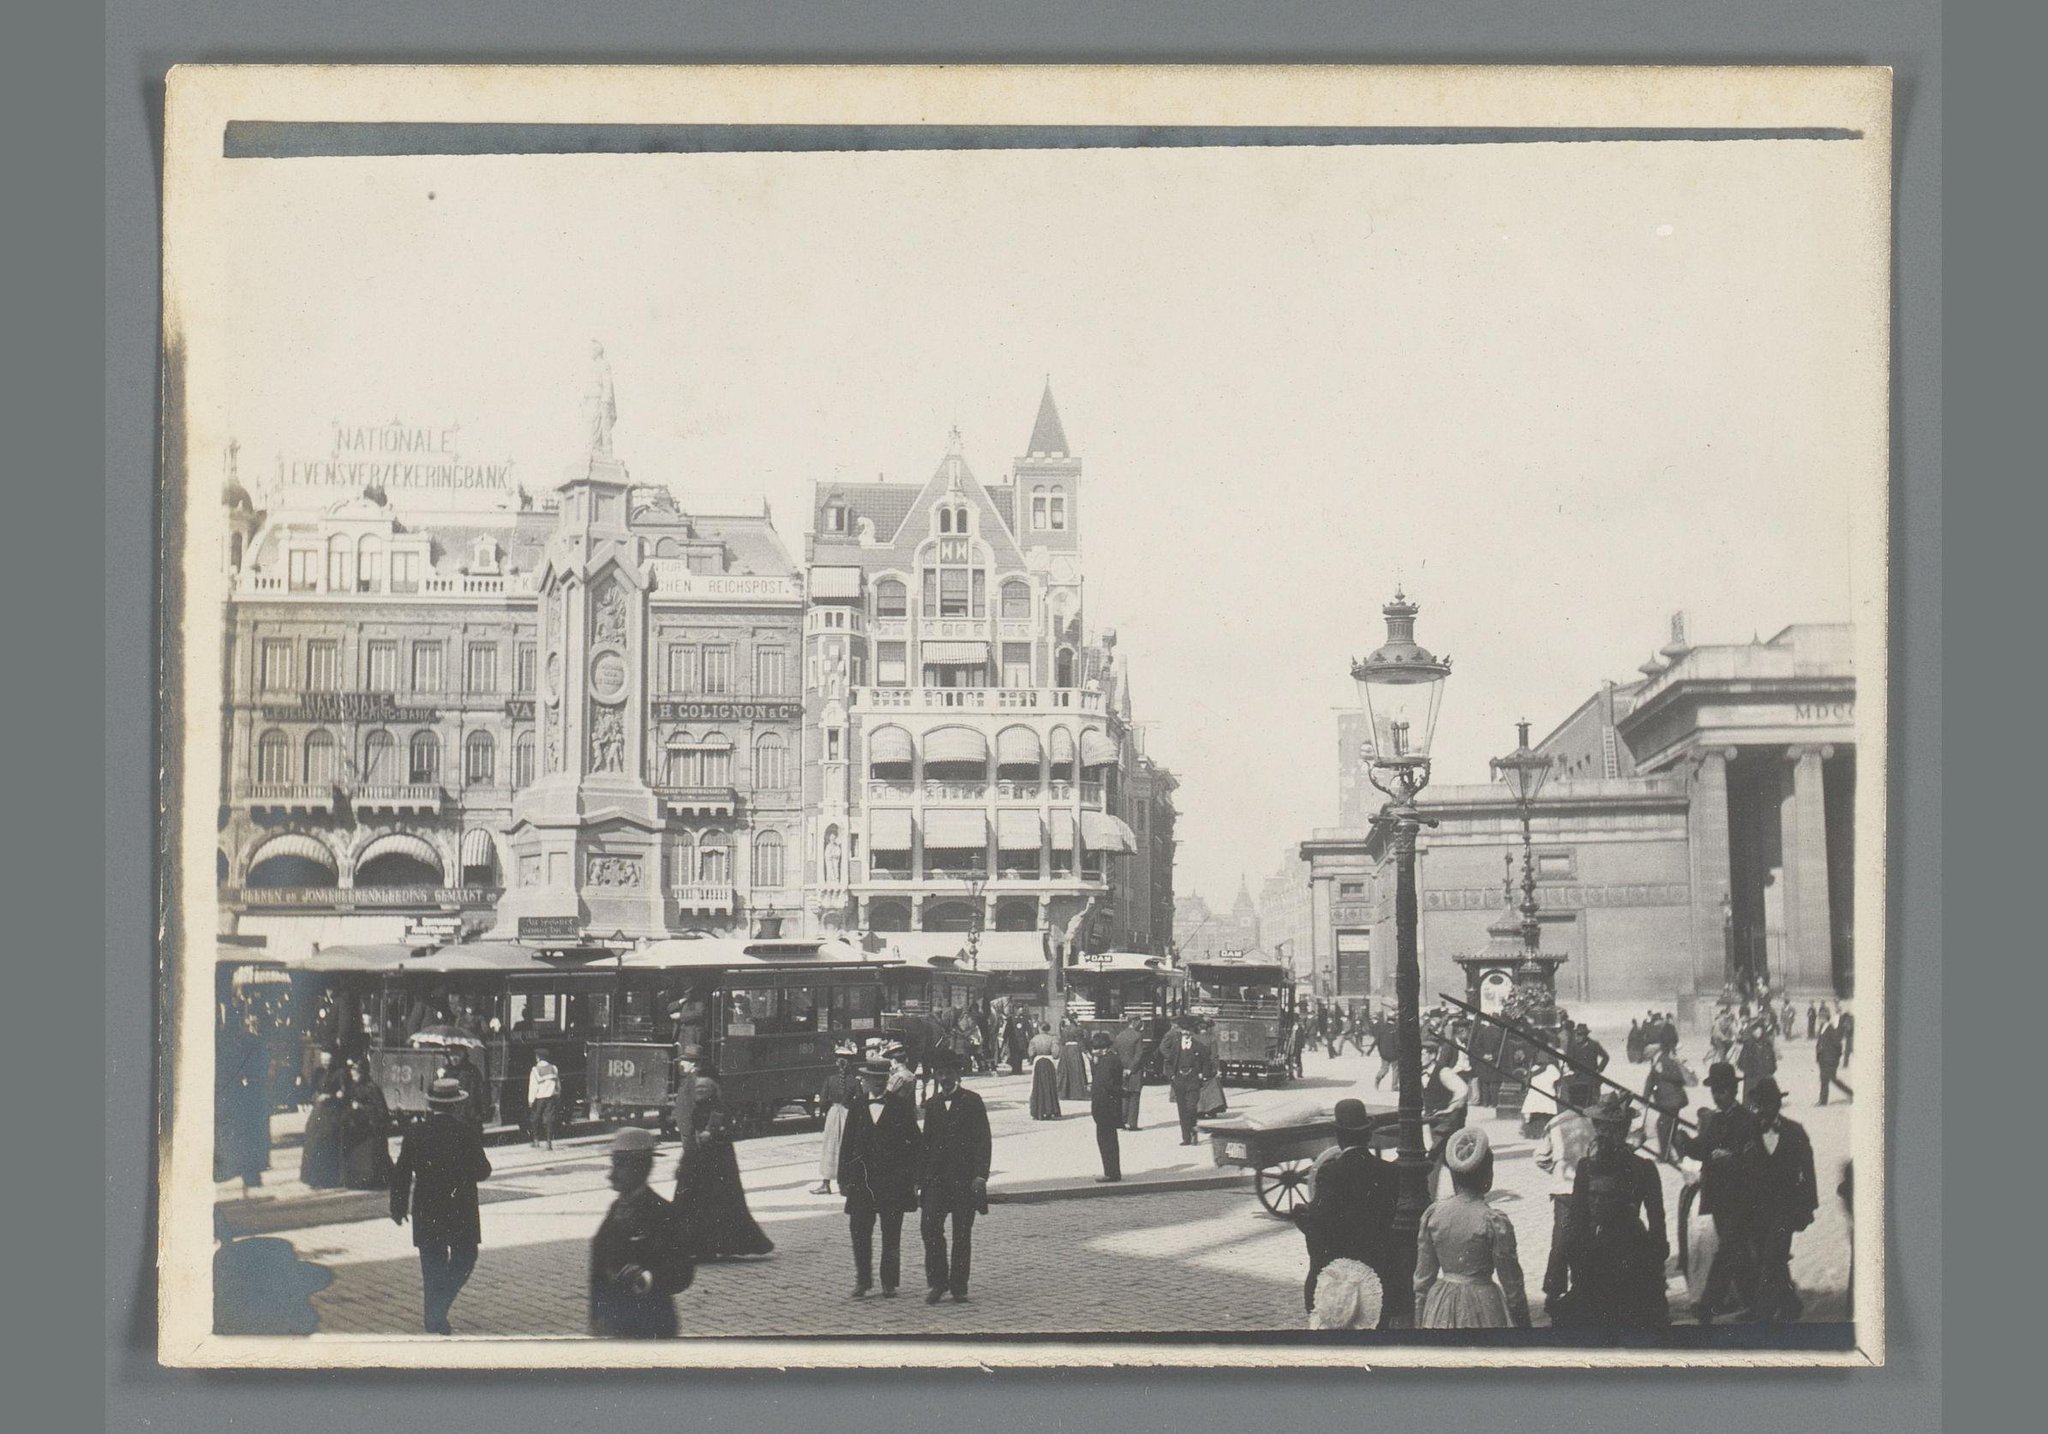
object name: photograph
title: Gezicht op de Dam met passanten en paardentrams, rechts de Beurs van Zocher, Amsterdam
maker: willem de jong (fotograaf)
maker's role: arts, fotograaf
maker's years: 1864-1918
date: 1895-1903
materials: paper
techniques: gelatin silver print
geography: amsterdam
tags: diligence, omnibus, horse-tram, stock exchange, stock-market, village square, place